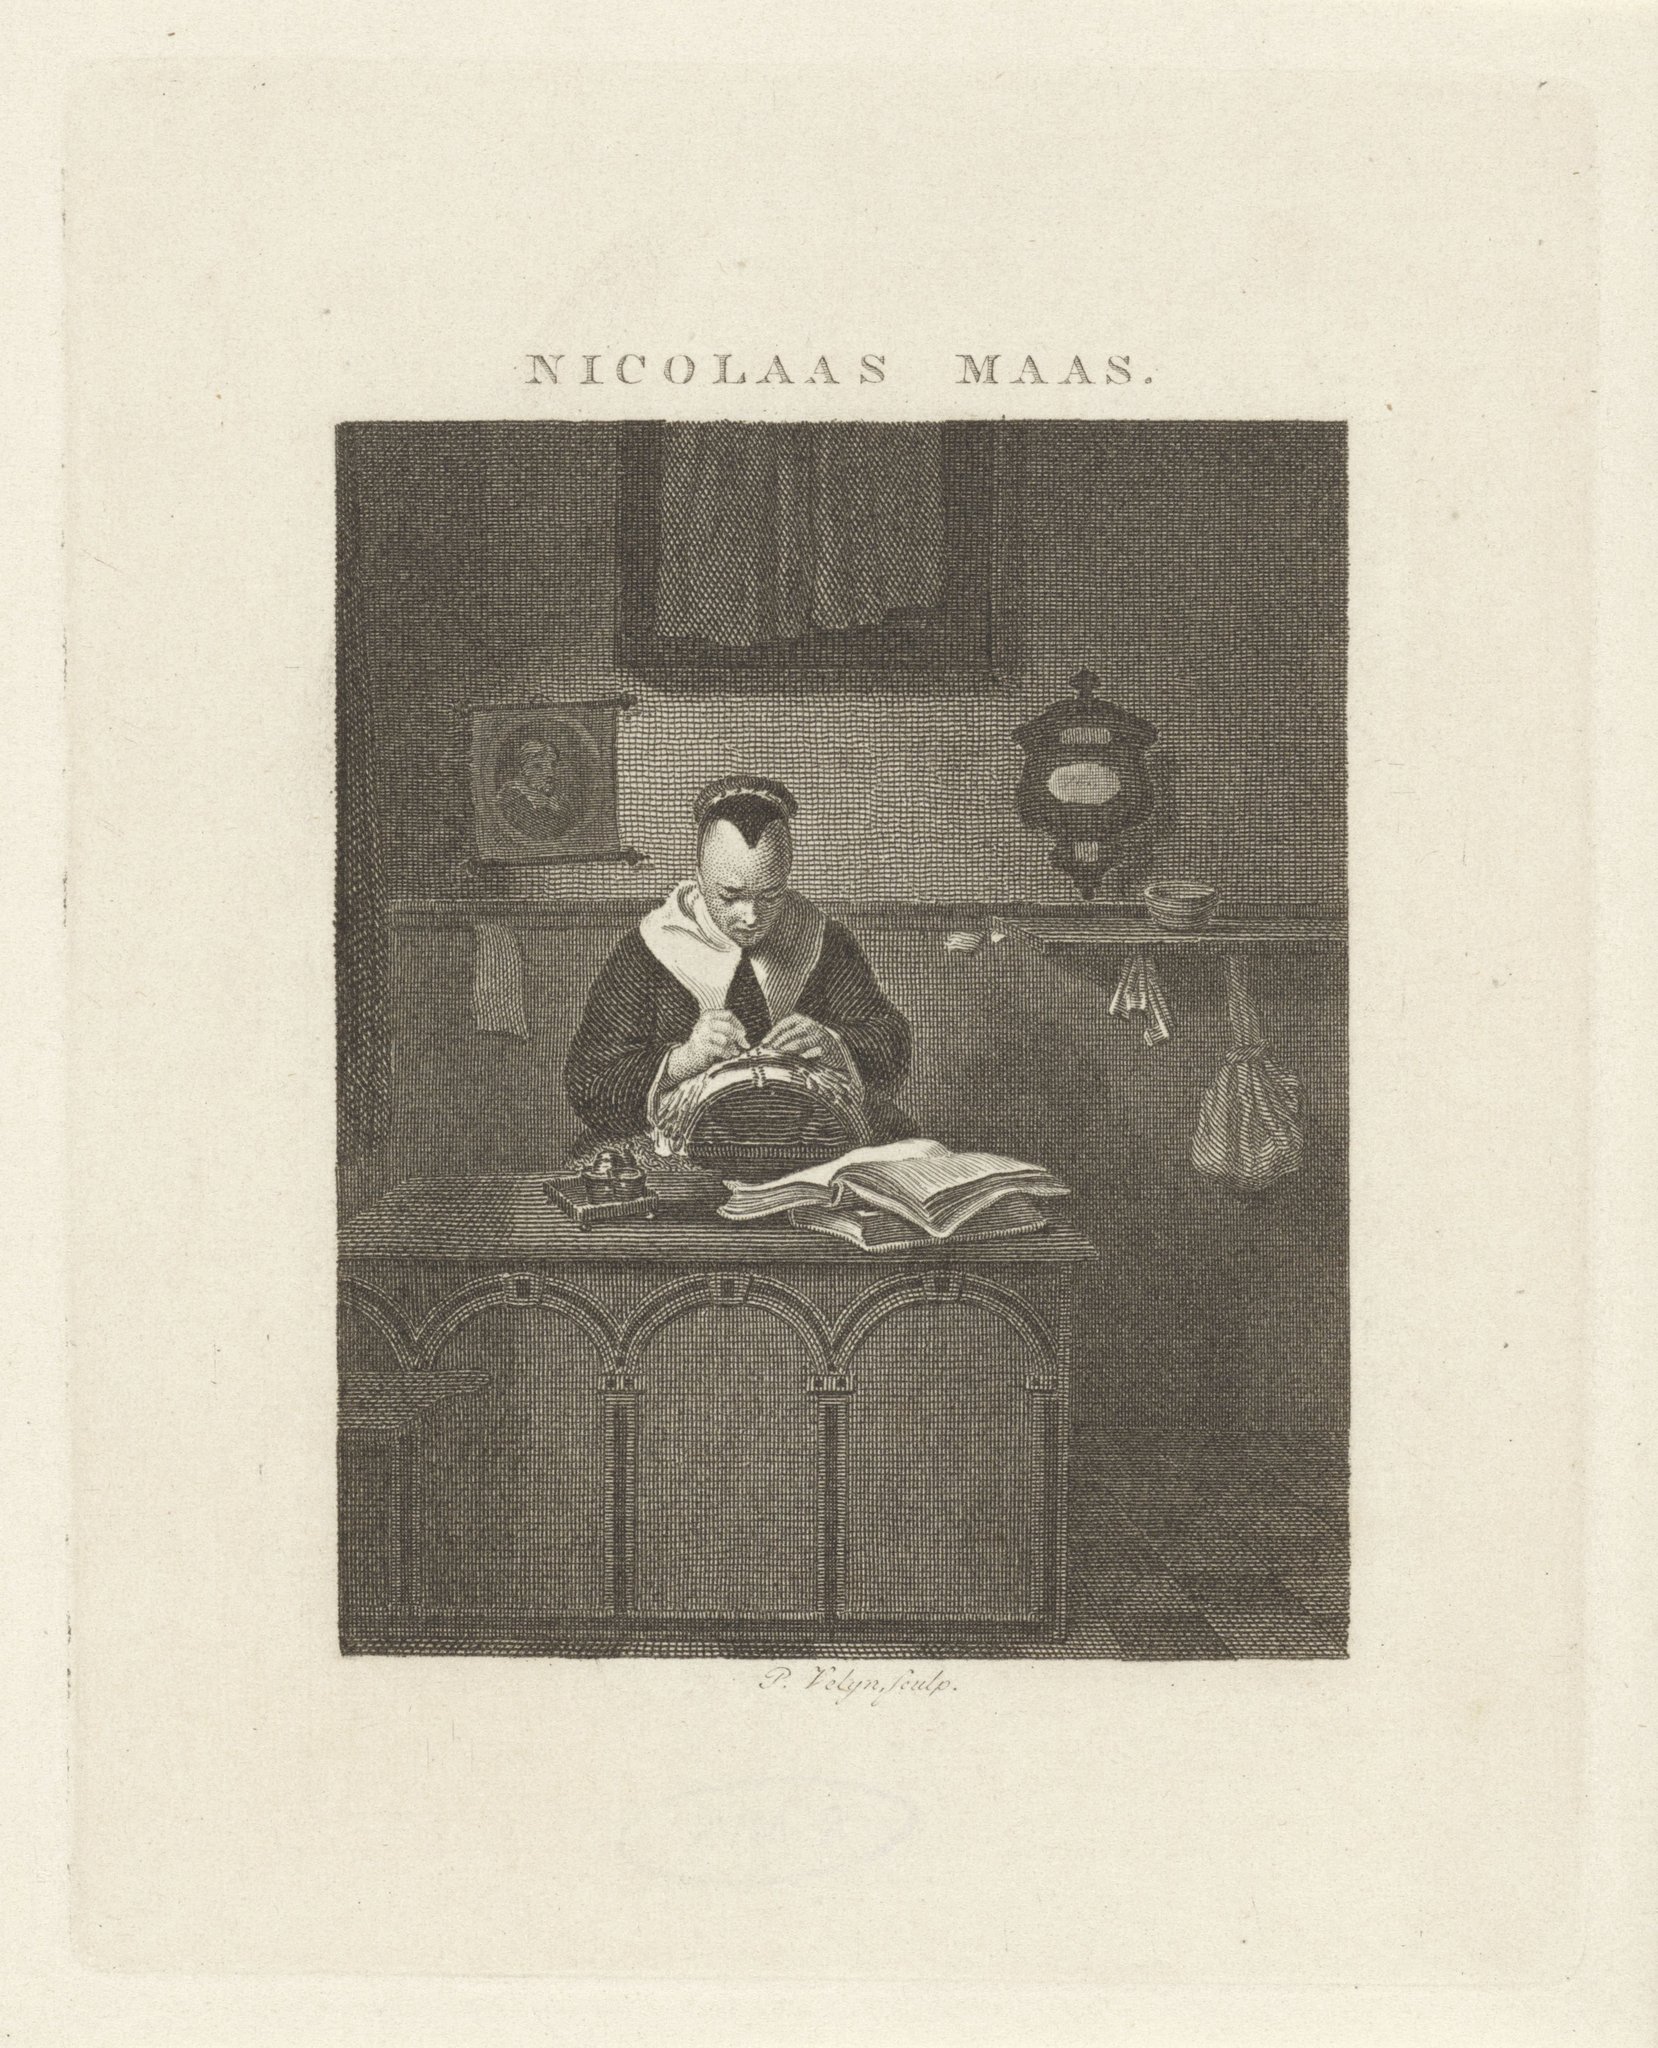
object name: print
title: Kantklossende vrouw in een interieur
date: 1797-1836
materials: paper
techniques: engraving, etching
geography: netherlands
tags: lace-making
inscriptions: collector's mark: Lugt 2228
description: Een zittende vrouw, bezig met kantklossen achter een dekenkist in een interieur.